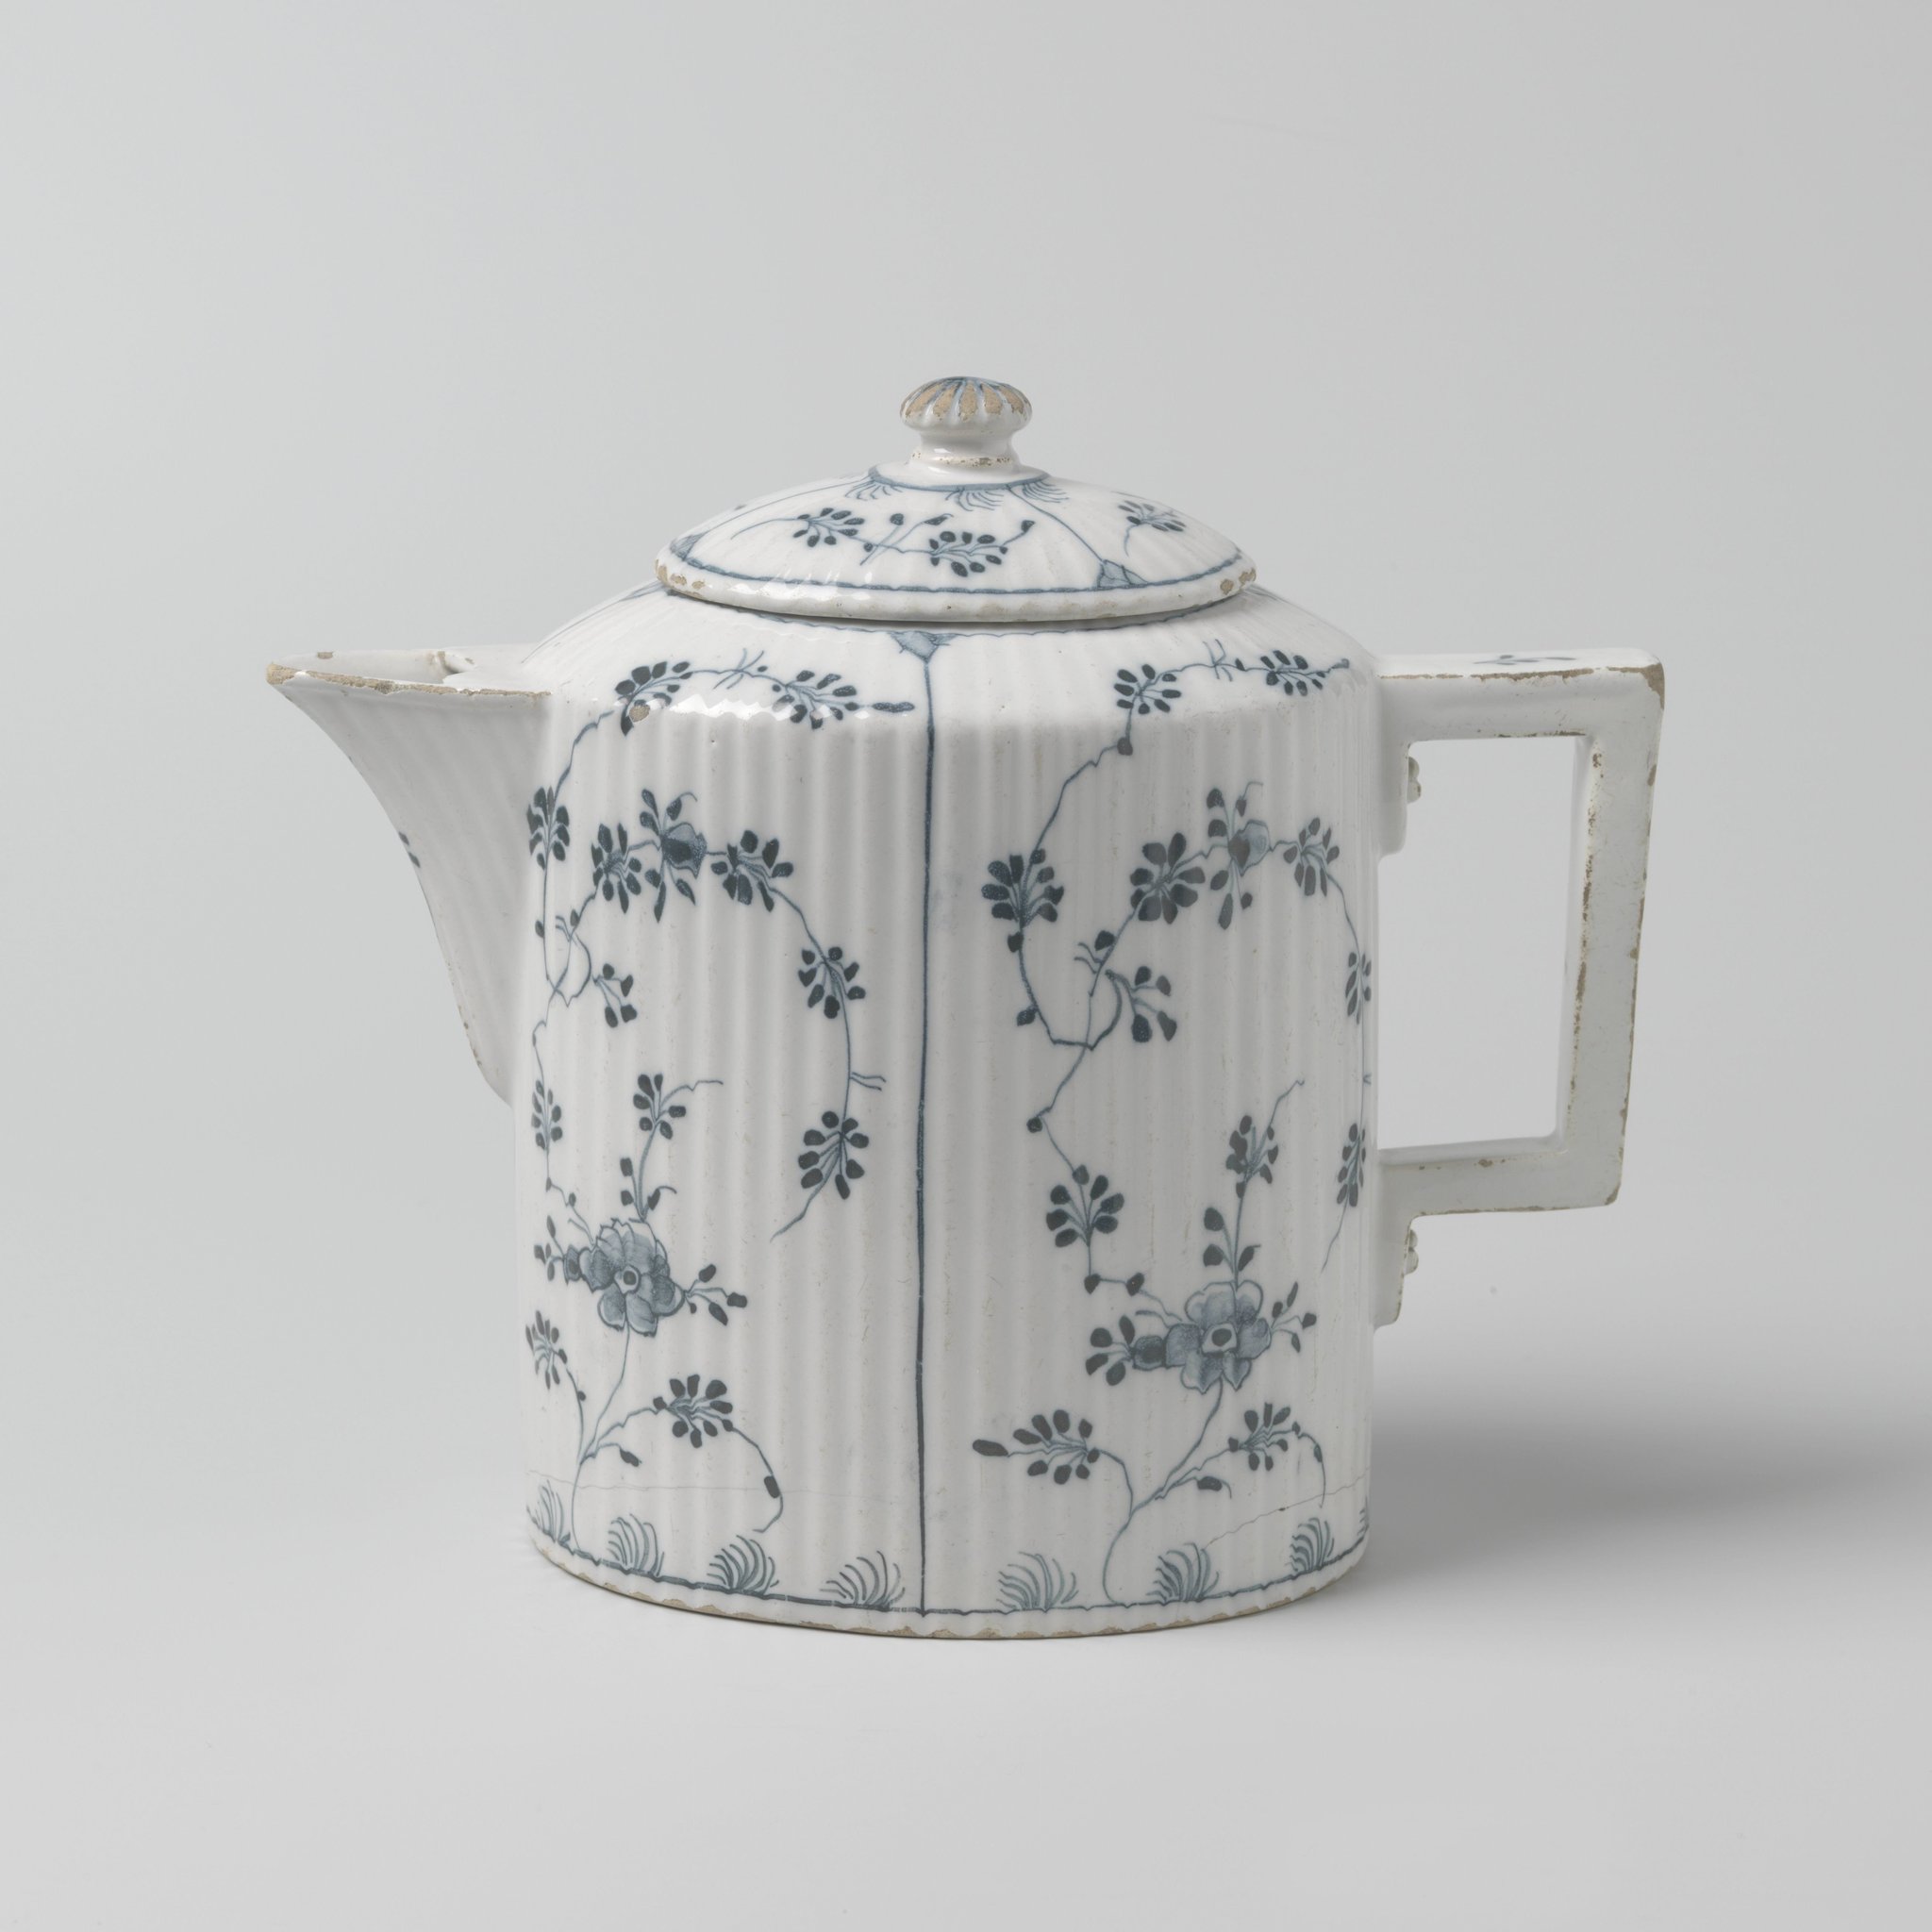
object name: pot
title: Koffiekan met deksel, beschilderd met bloemenranken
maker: Anonymous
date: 1780-1830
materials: earthenware, glaze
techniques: painted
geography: germany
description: Ovale, cilindrische, geribde koffiepot van blauw beschilderde faience met een rechthoekig oor, een gedeukte sneb en een gewelfd deksel met knop. Op de koffiepot zijn bloemenranken geschilderd. De pot is gemerkt.